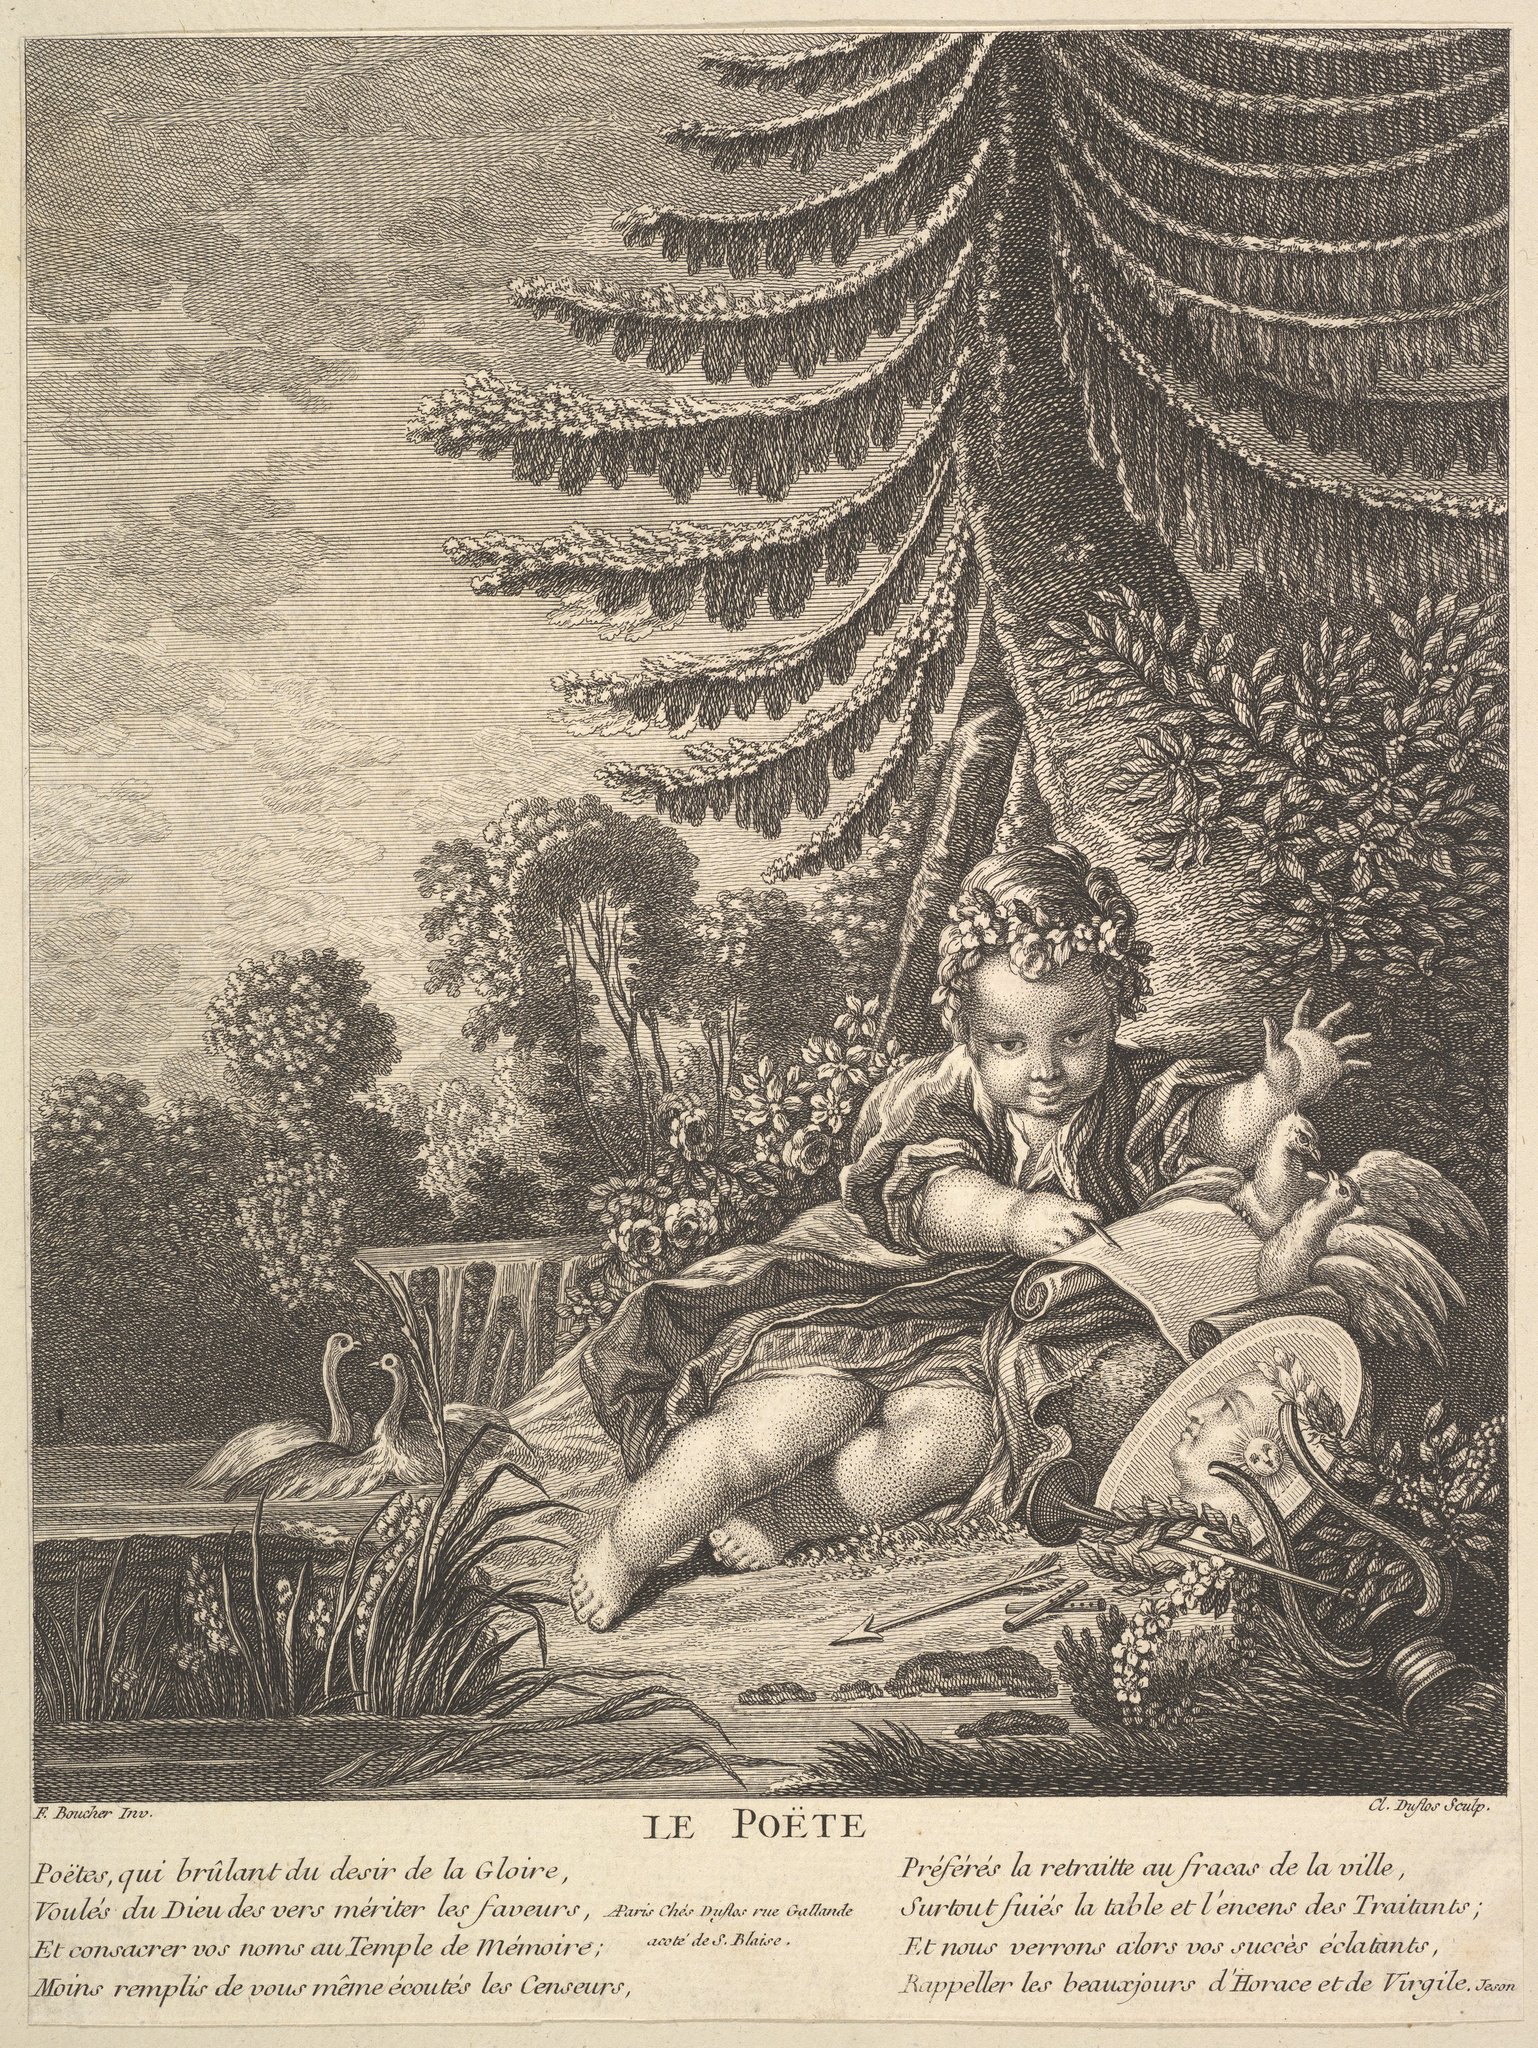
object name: print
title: The Poet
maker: claude augustin duflos le jeune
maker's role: artist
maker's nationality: french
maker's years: 1700-1786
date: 1753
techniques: engraving, etching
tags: birds,children,writing